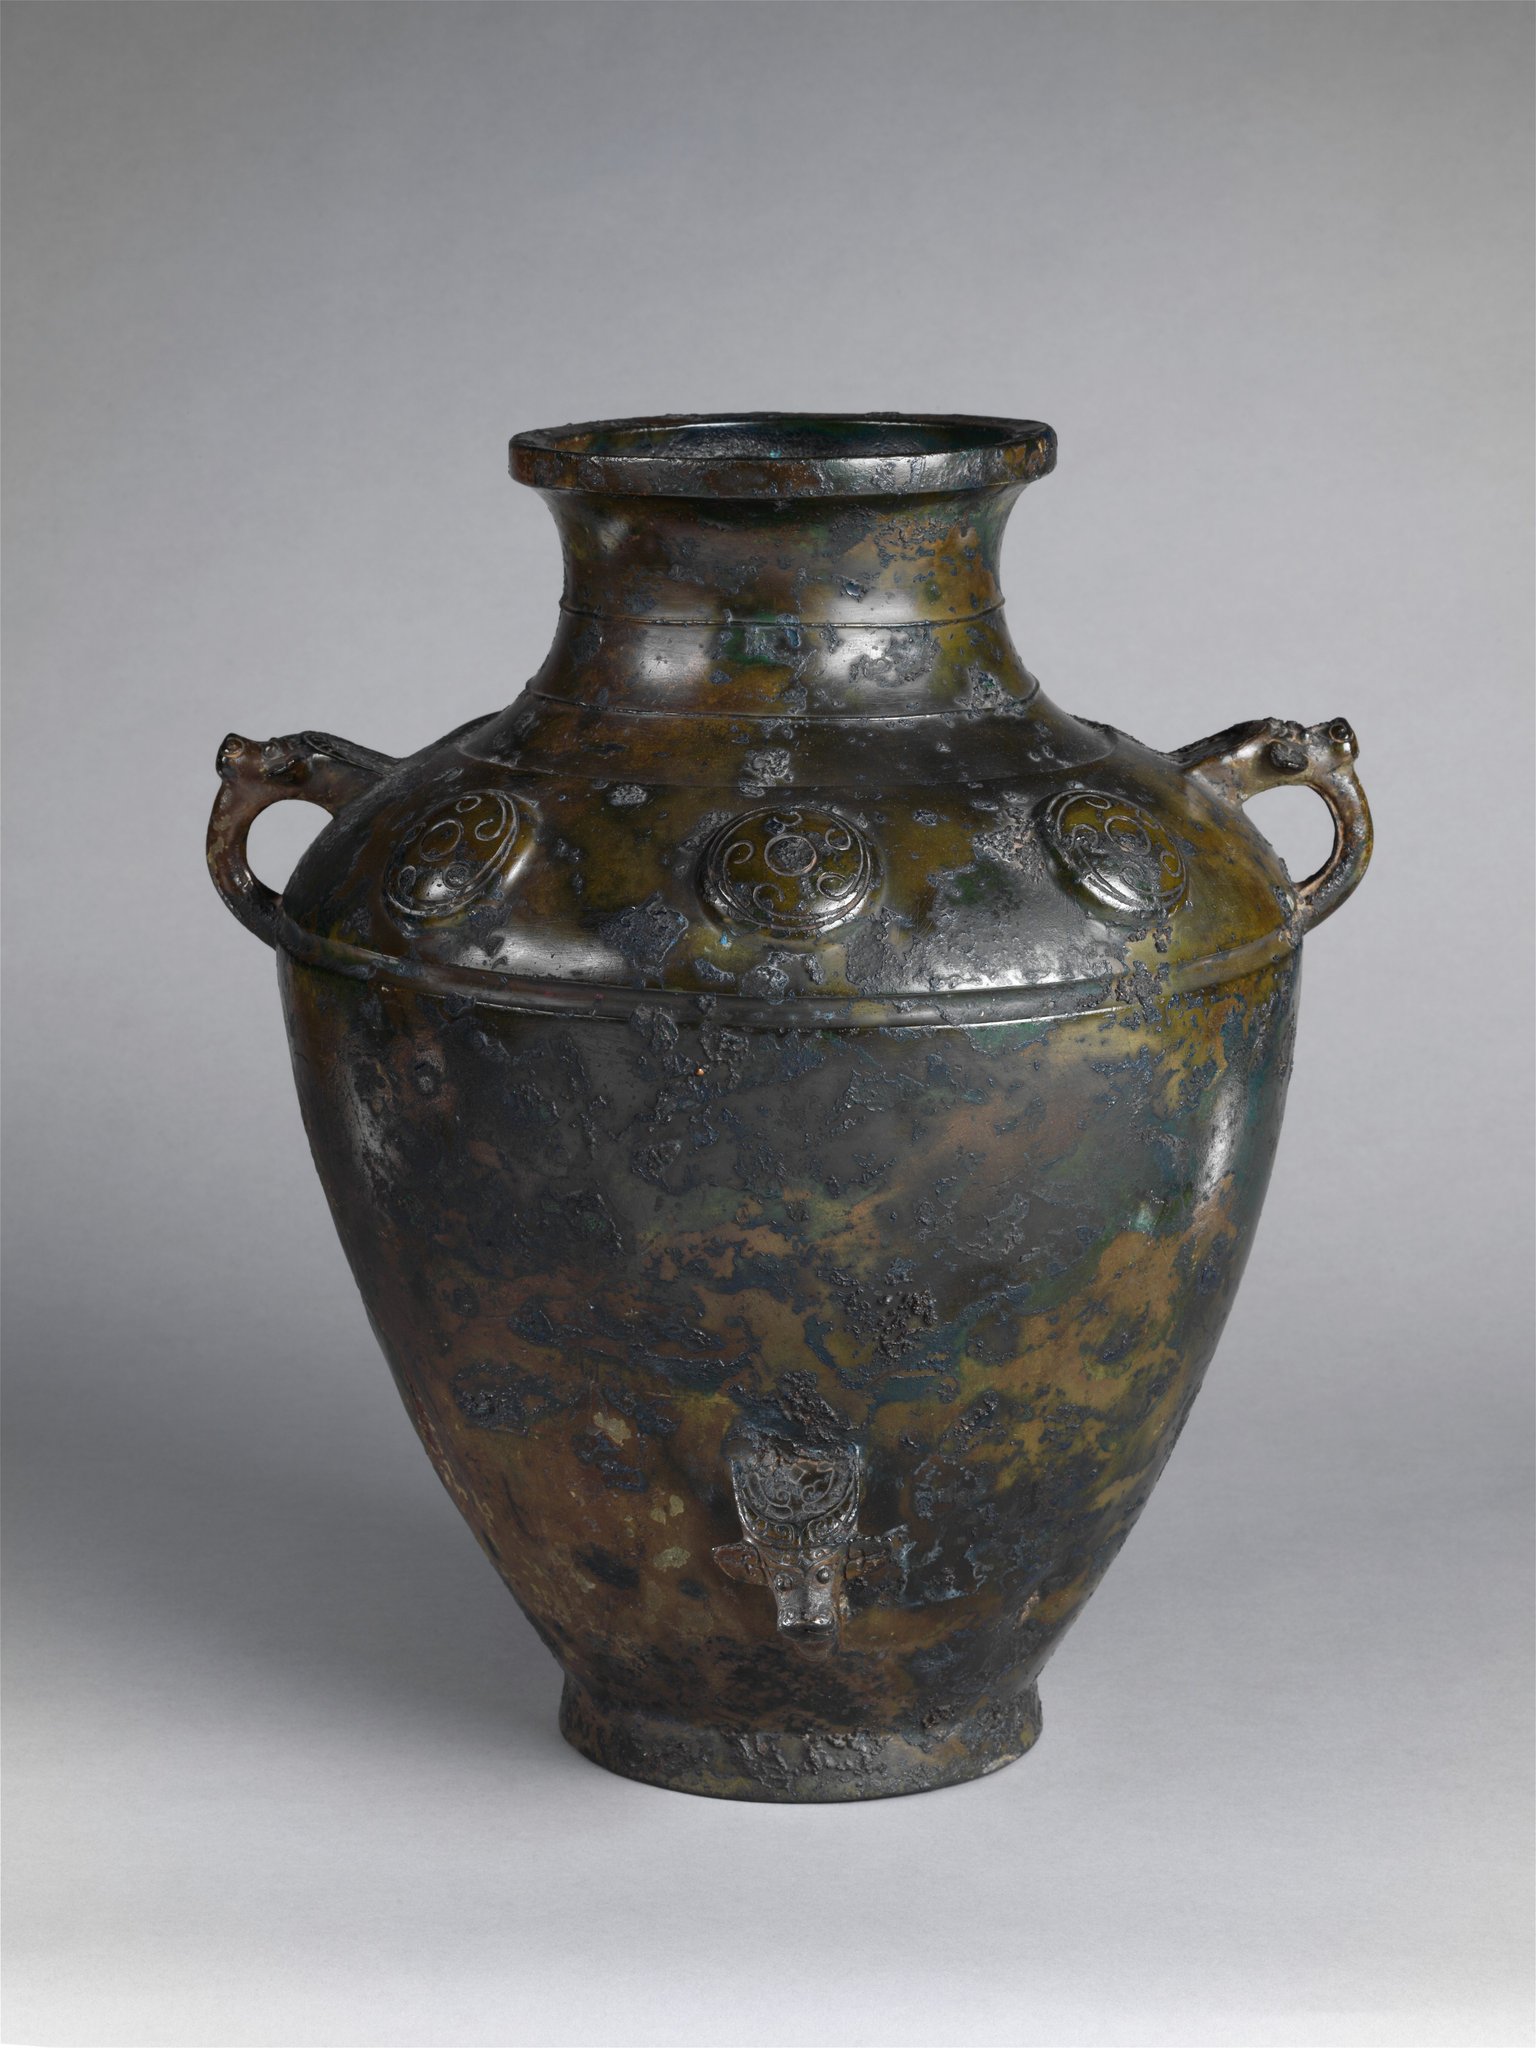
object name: wine container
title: Wine container (lei)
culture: chinese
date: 1200-901 BCE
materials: bronze